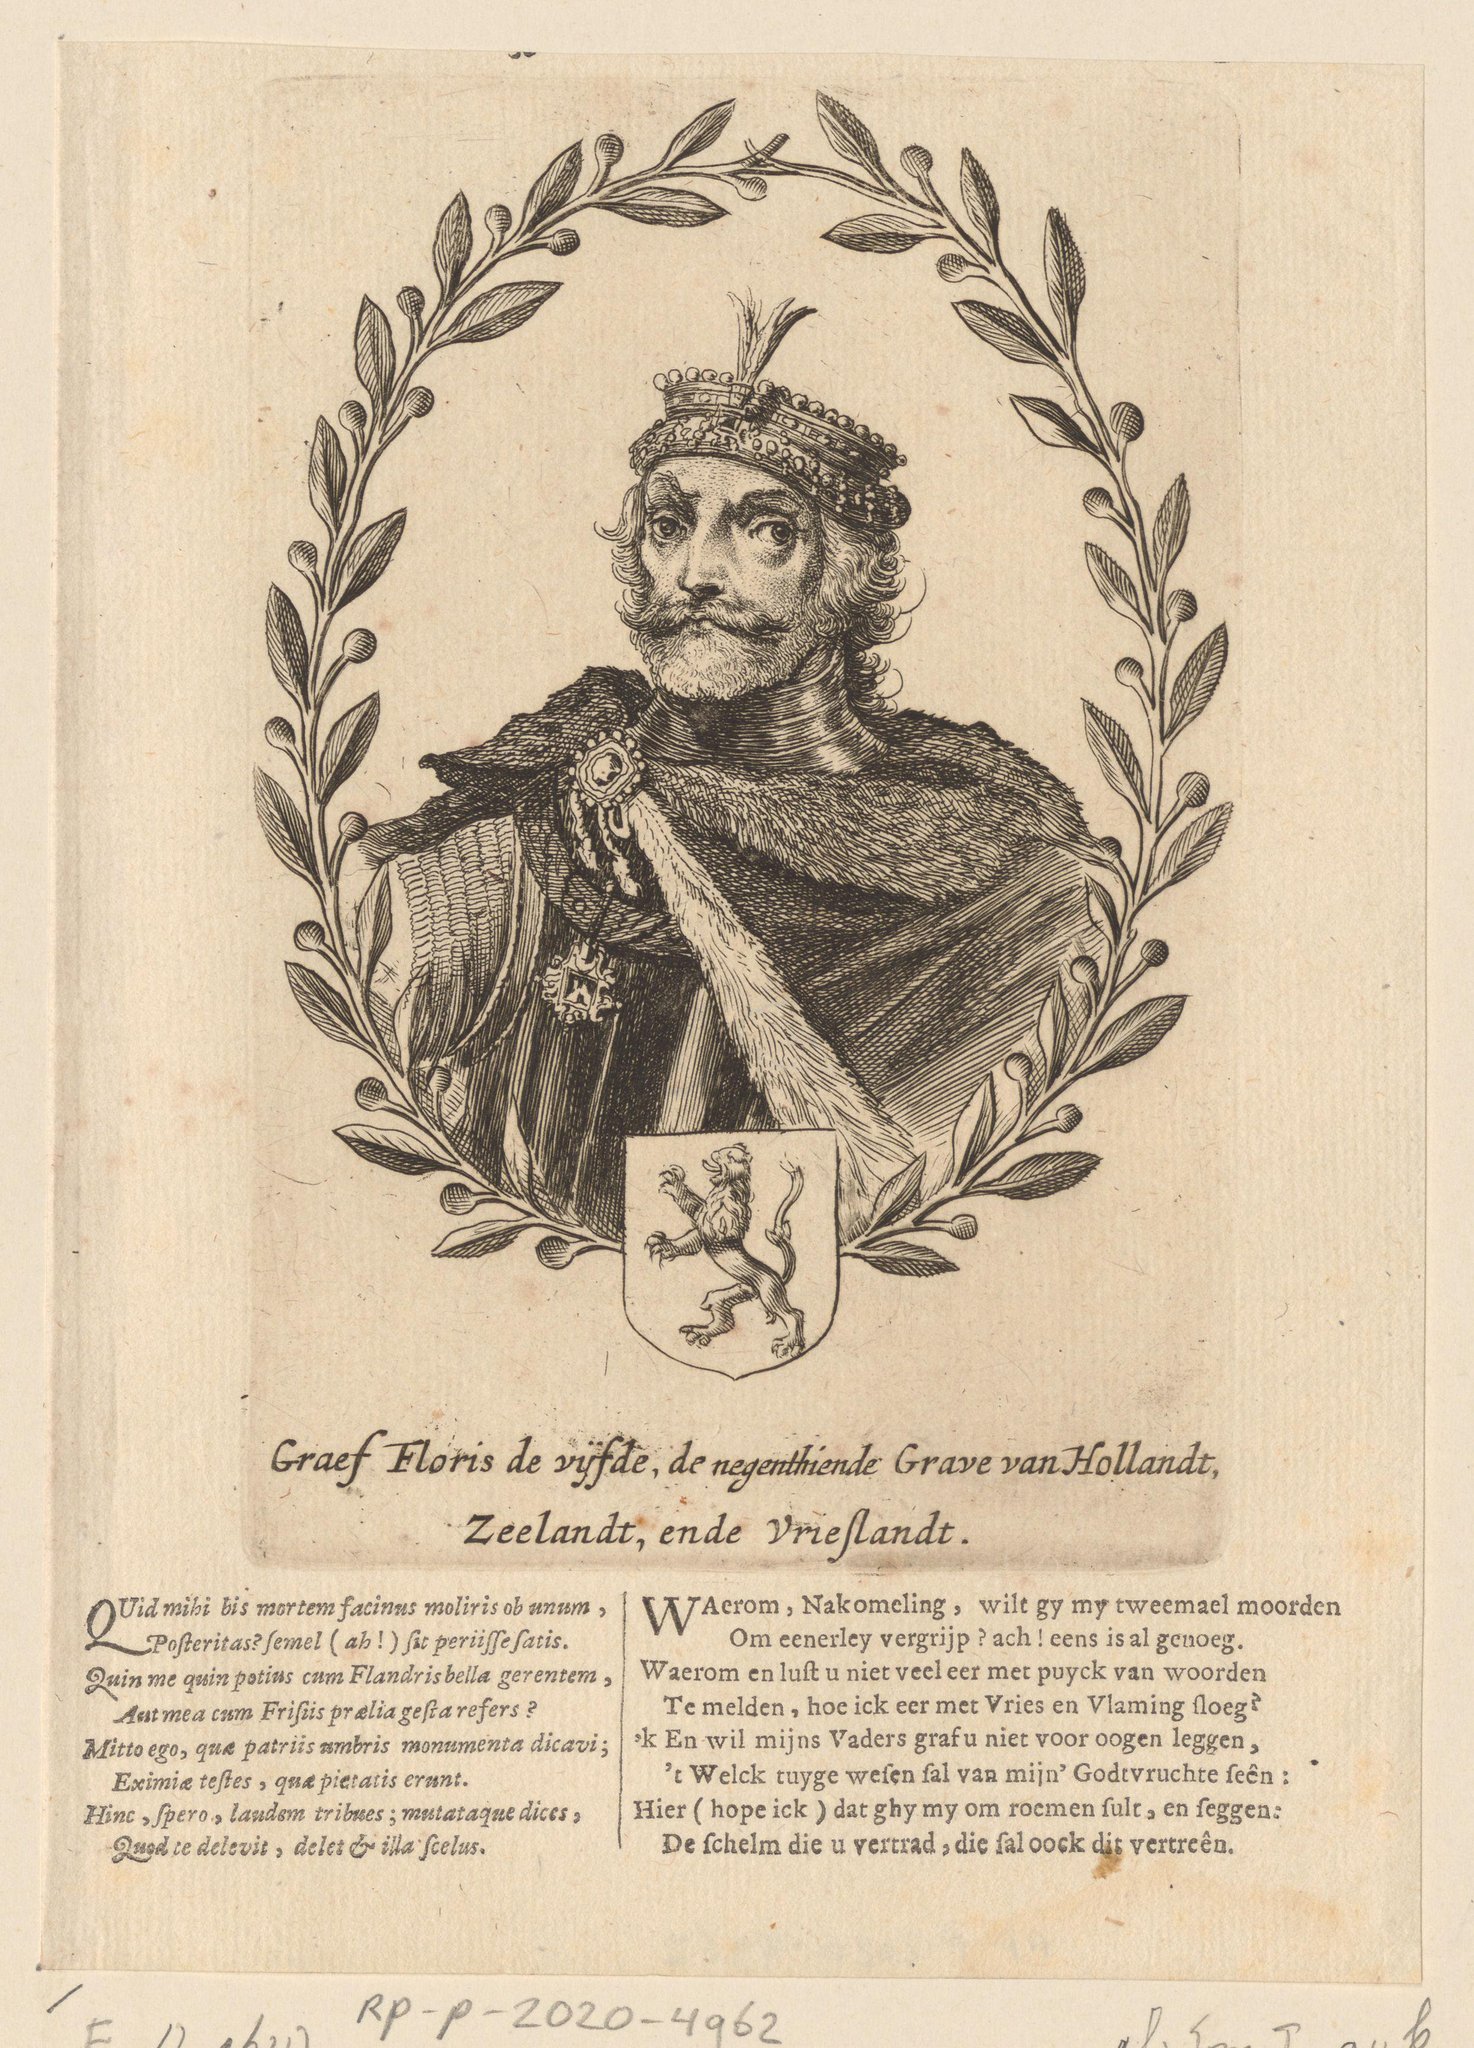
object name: print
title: Portret van Floris V, graaf van Holland en Zeeland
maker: Anonymous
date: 1678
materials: paper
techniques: engraving, etching, letterpress printing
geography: northern netherlands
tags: floris iv (graaf van holland), coat of arms (as symbol of the state, etc.), crown (symbol of sovereignty), armour, historical persons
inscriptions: collector's mark: Lugt 964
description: Prent waarschijnlijk uit: Scriverius, Petrus. Hollandsche, Zeelandsche ende Vriesche Chronyck (...). Den Haag: Johann Veely en Jasper Doll, 1678. Eerdere staat gebruikt in 'Oude Hollandsche Geschiedenissen (...)' van Wachtendorp, 1645.